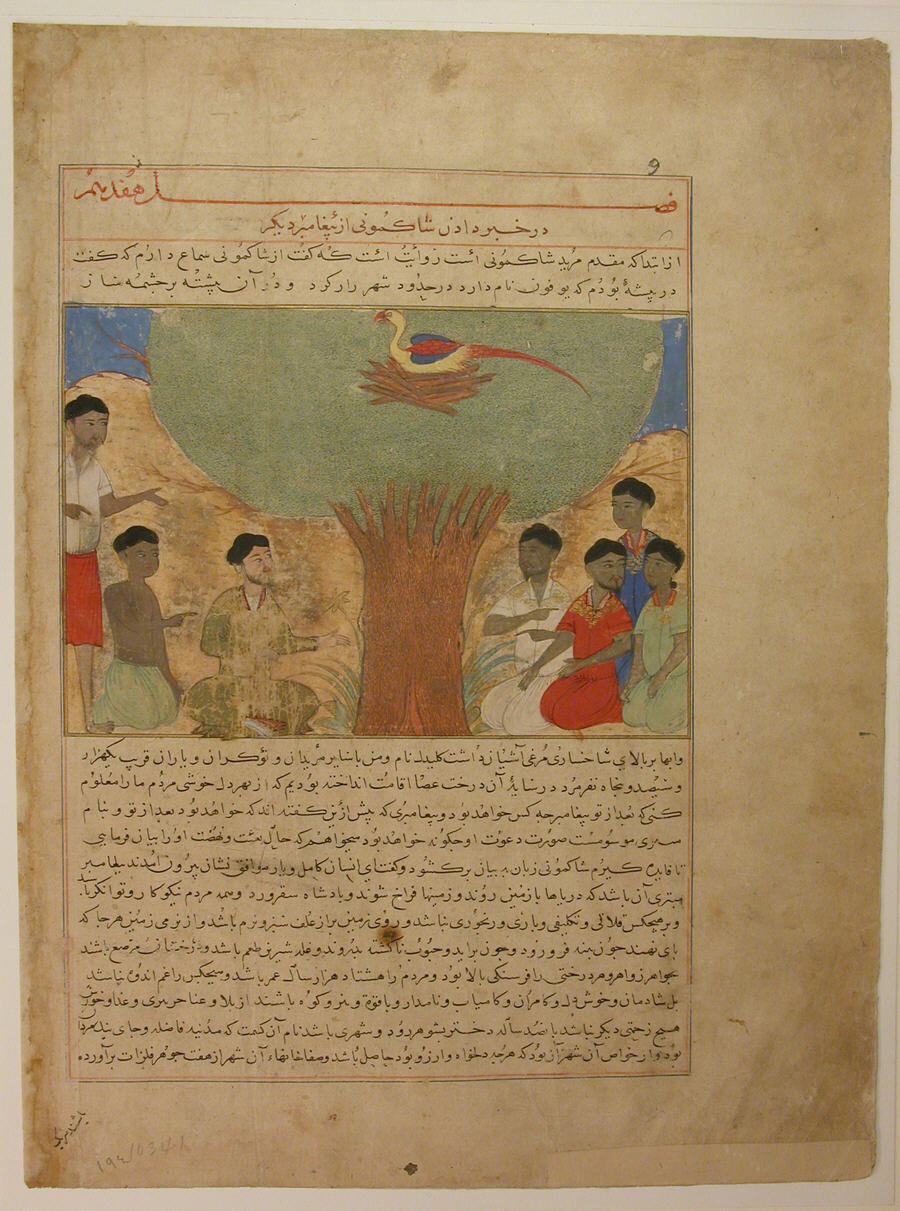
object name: folio from an illustrated manuscript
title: "Sakyamuni (Buddha) Announces Another Prophet", Folio from a Majma al-Tavarikh (Compendium of Histories)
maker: hafiz-i abru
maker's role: author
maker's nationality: iranian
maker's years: 1350-1430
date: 1425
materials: gold, paper, silver, watercolor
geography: afghanistan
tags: birds,men,trees